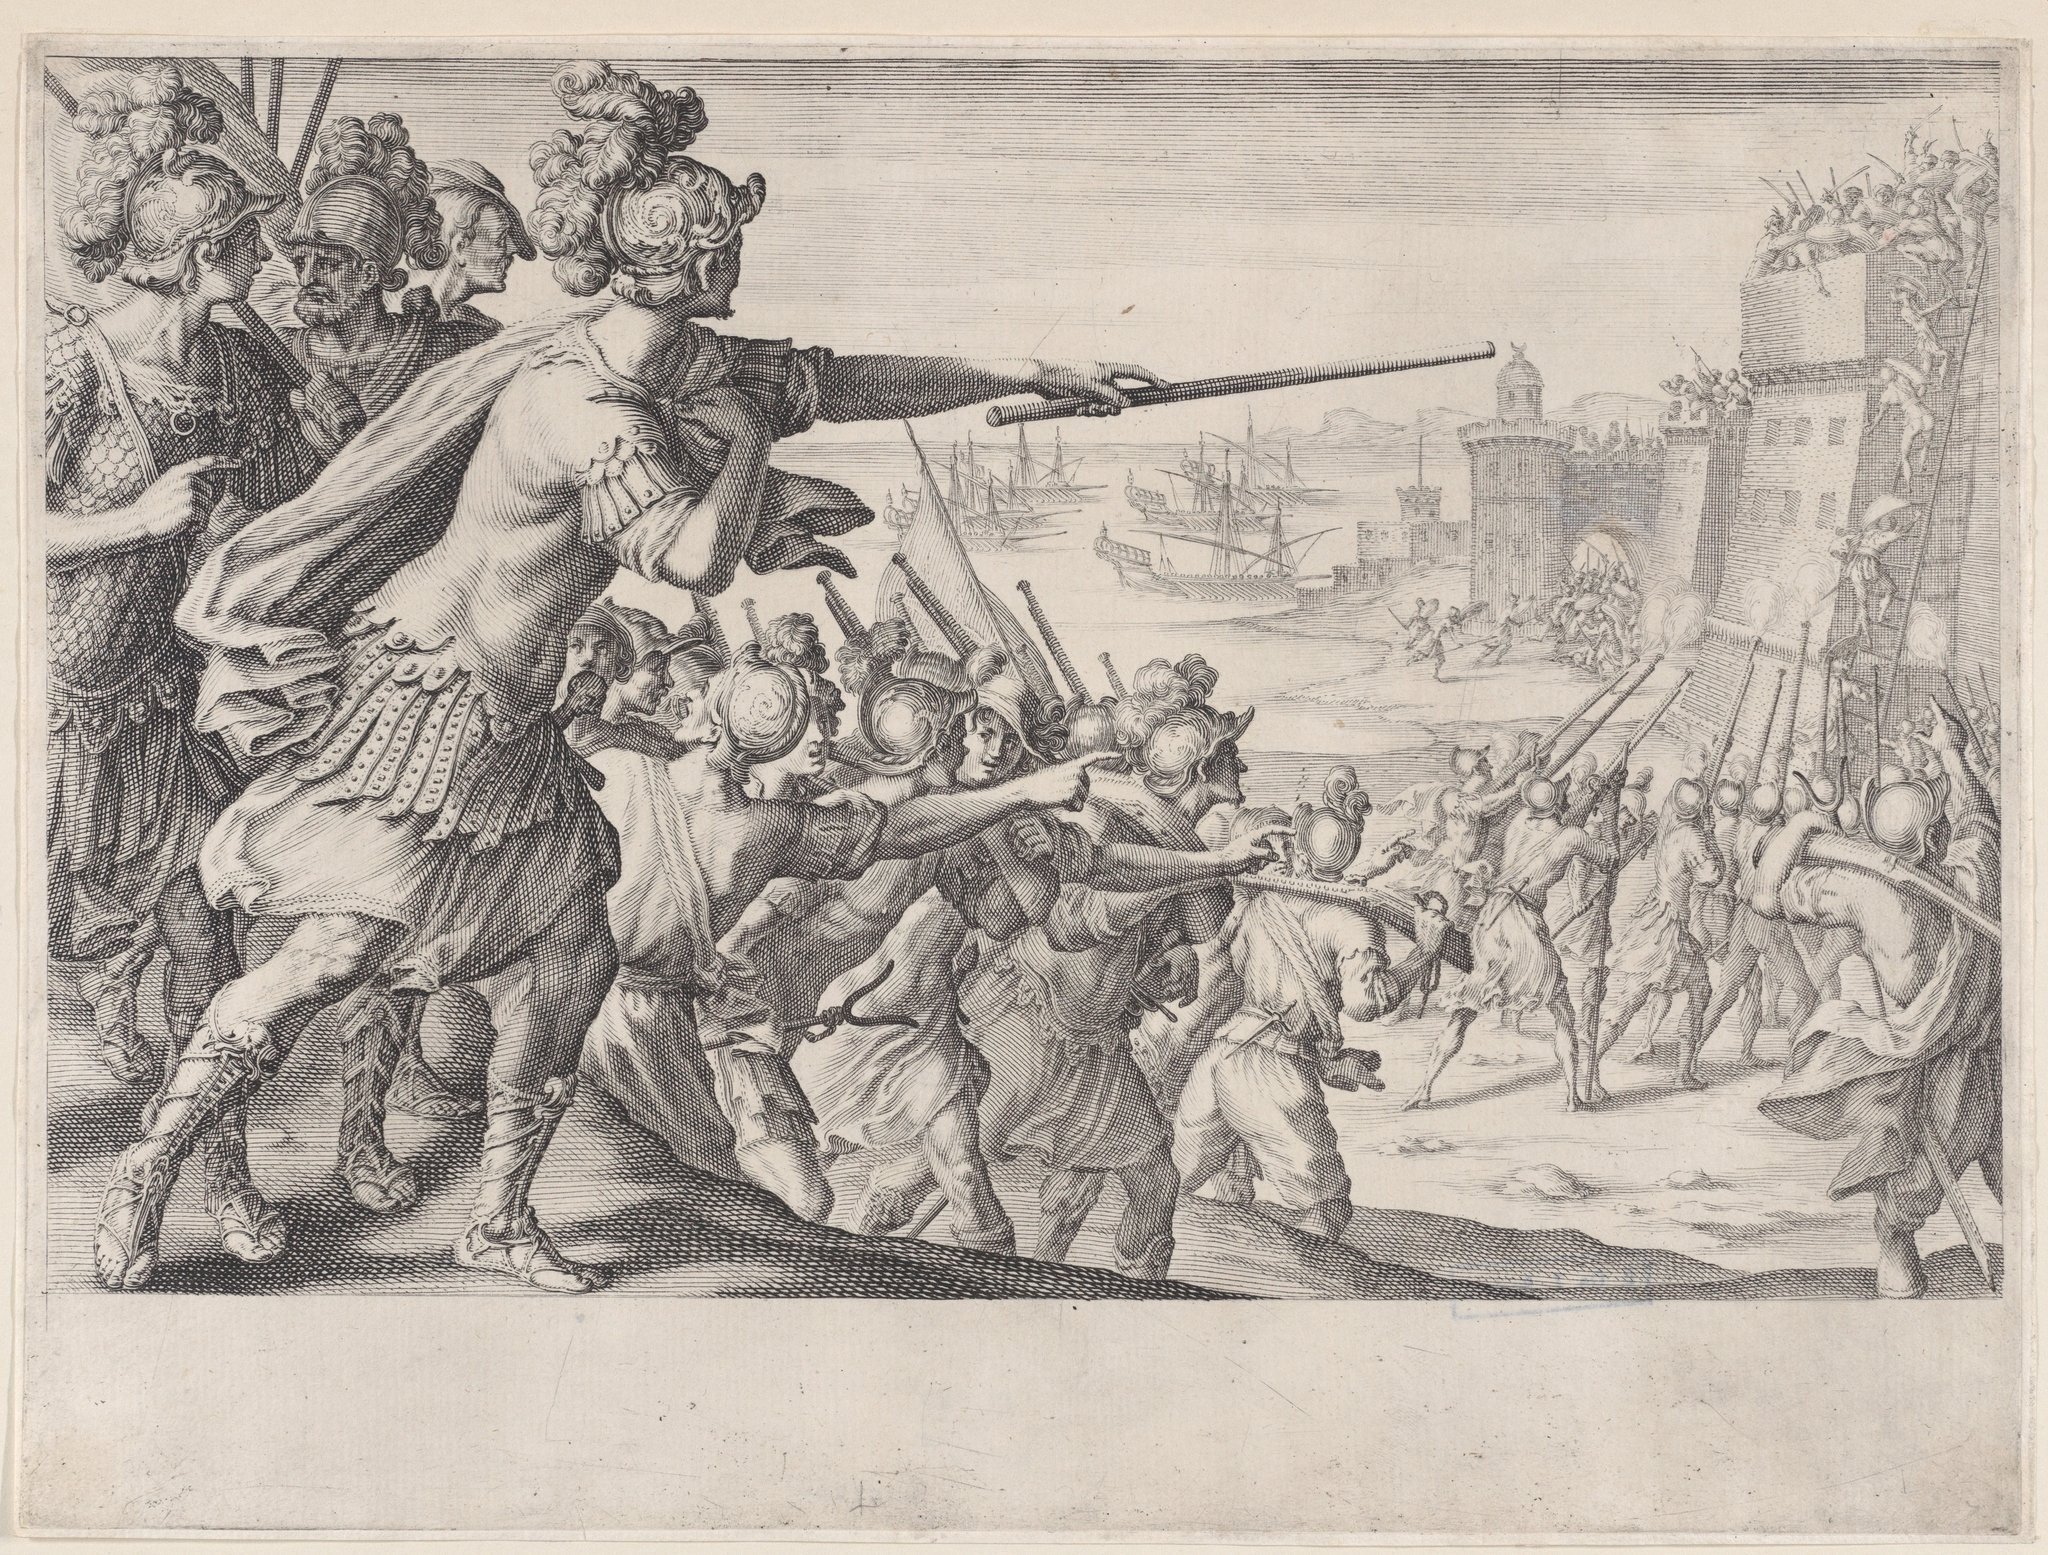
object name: print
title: Prise de la Ville de Bone (Capture of the City of Bonne), from "La Vie de Ferdinand Ier de Médicis série appelée aussi Les Batailles des Médicis" (The Life of Ferdinand I de'Medici also called The Medici Battles)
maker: jacques callot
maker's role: artist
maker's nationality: french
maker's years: 1592-1635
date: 1614-1620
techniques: engraving